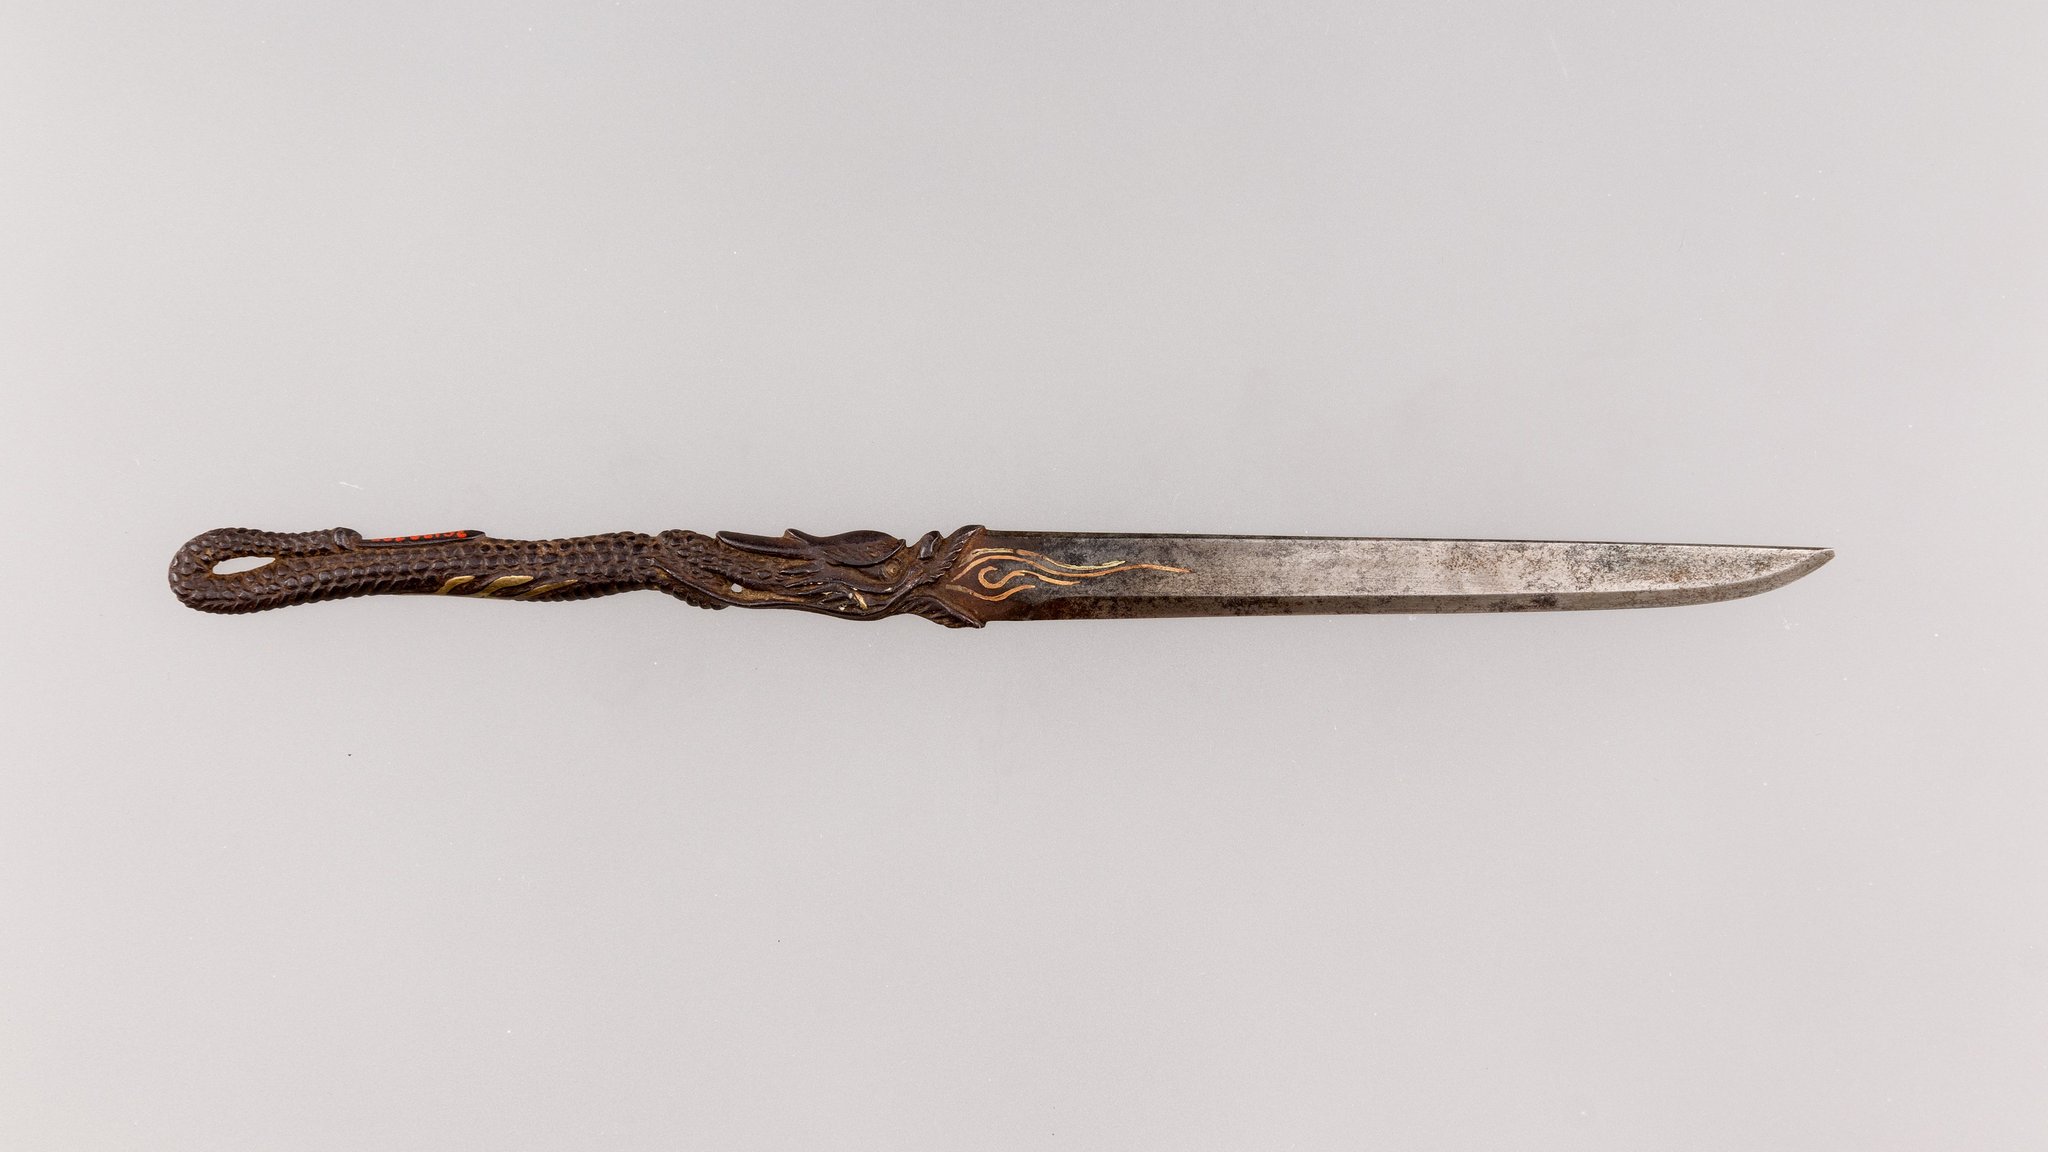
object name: knife handle kozuka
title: Knife Handle (Kozuka) with Blade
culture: japanese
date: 1501-1600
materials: gold, steel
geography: japan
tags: dragons